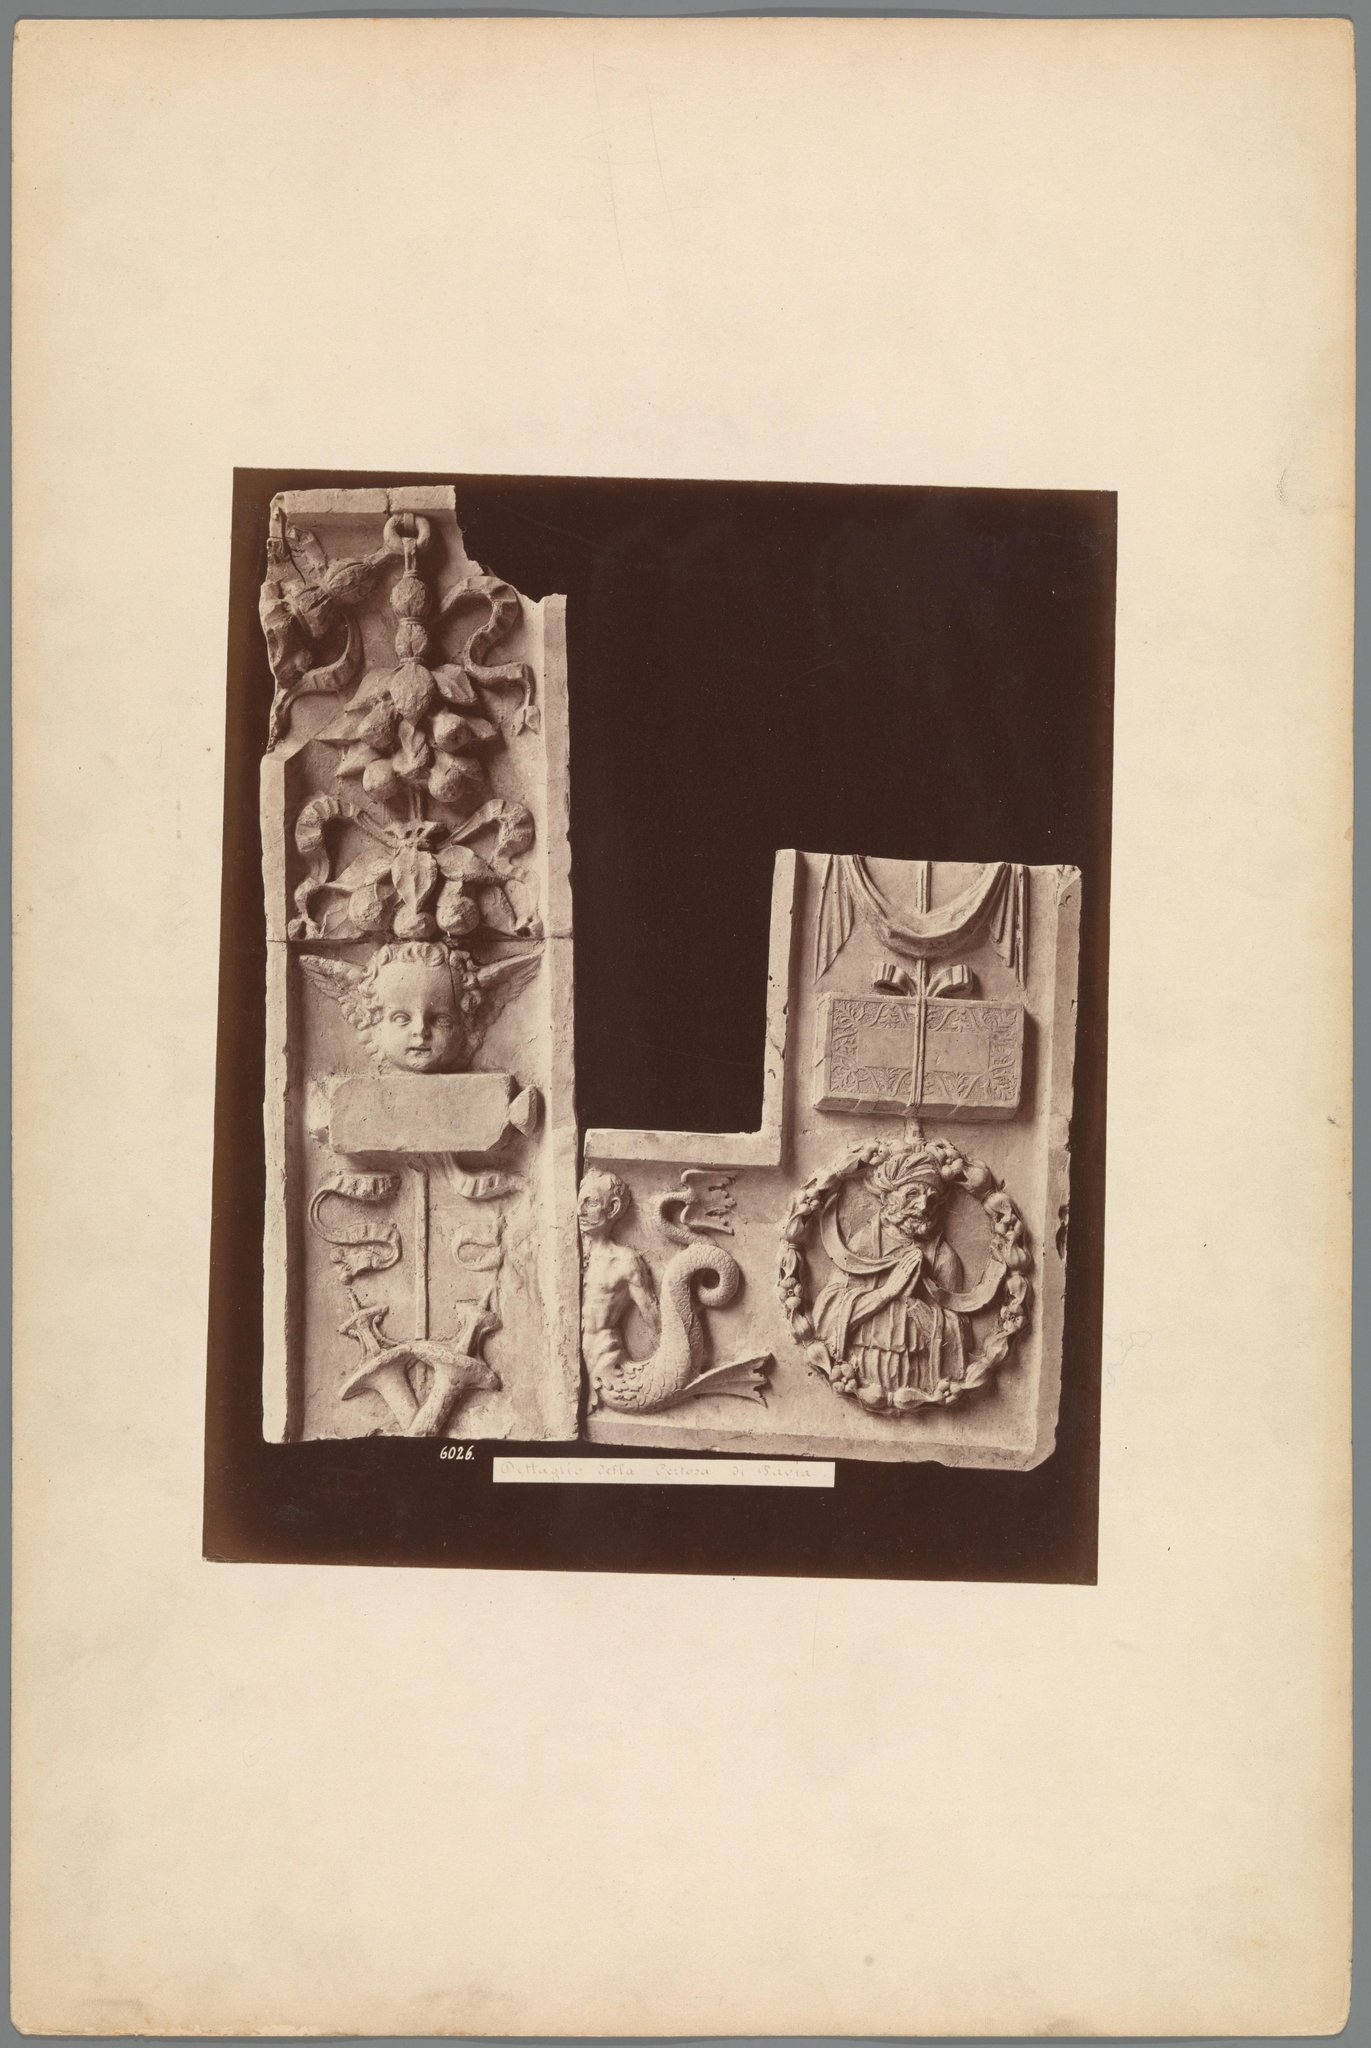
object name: photograph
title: Twee reliëfs afkomstig uit het kartuizerklooster van Pavia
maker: Anonymous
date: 1875-1900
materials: cardboard, photographic support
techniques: albumen print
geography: europe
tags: monsters of the sea, old man, ornament ~ festoon, garland, cupids: 'amores', 'amoretti', 'putti', sculpture (+ relief ~ sculpture)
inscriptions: collector's mark: Lugt 3937, number: ‘6026.’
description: Links een reliëf met een putto en een guirlande, rechts een reliëf met een zeewezen en een oude man met een tulband.